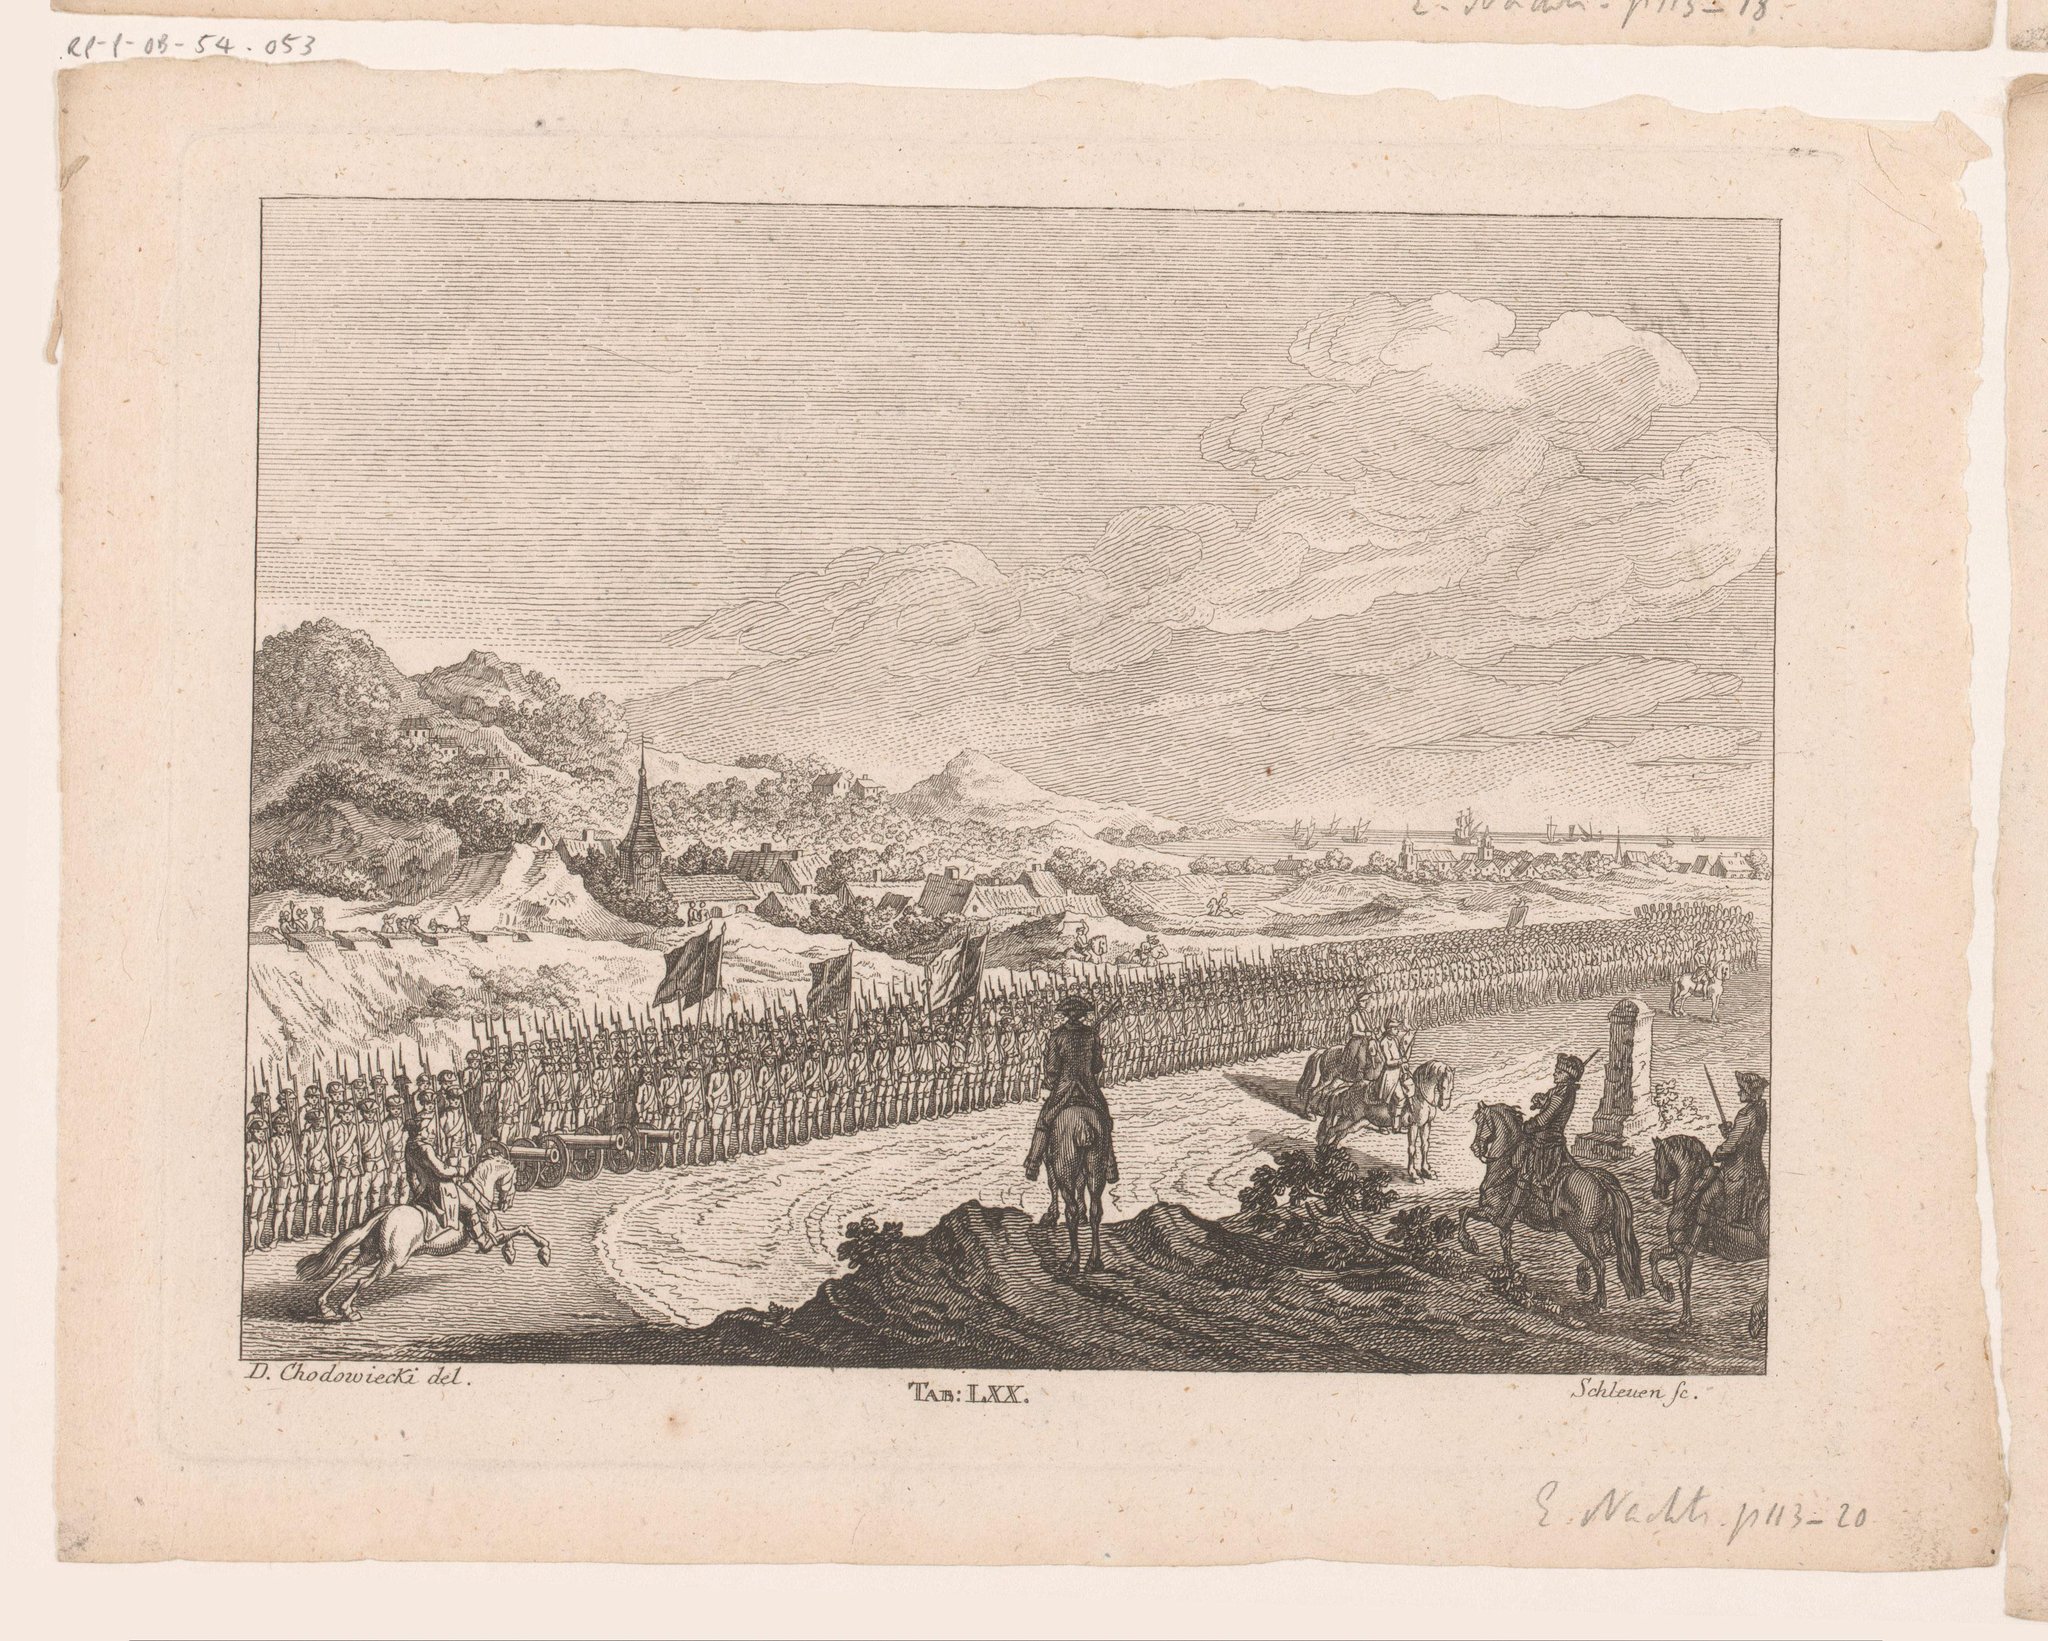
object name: print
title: Vier encyclopedische voorstellingen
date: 1765-1806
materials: paper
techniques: etching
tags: military parade, pageant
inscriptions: collector's mark: Lugt 2228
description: Prent ook gebruikt in: Allgemeine deutsche Bibliothek. Berlijn en Stettin: Friedrich Nicolai, 1765-1806.